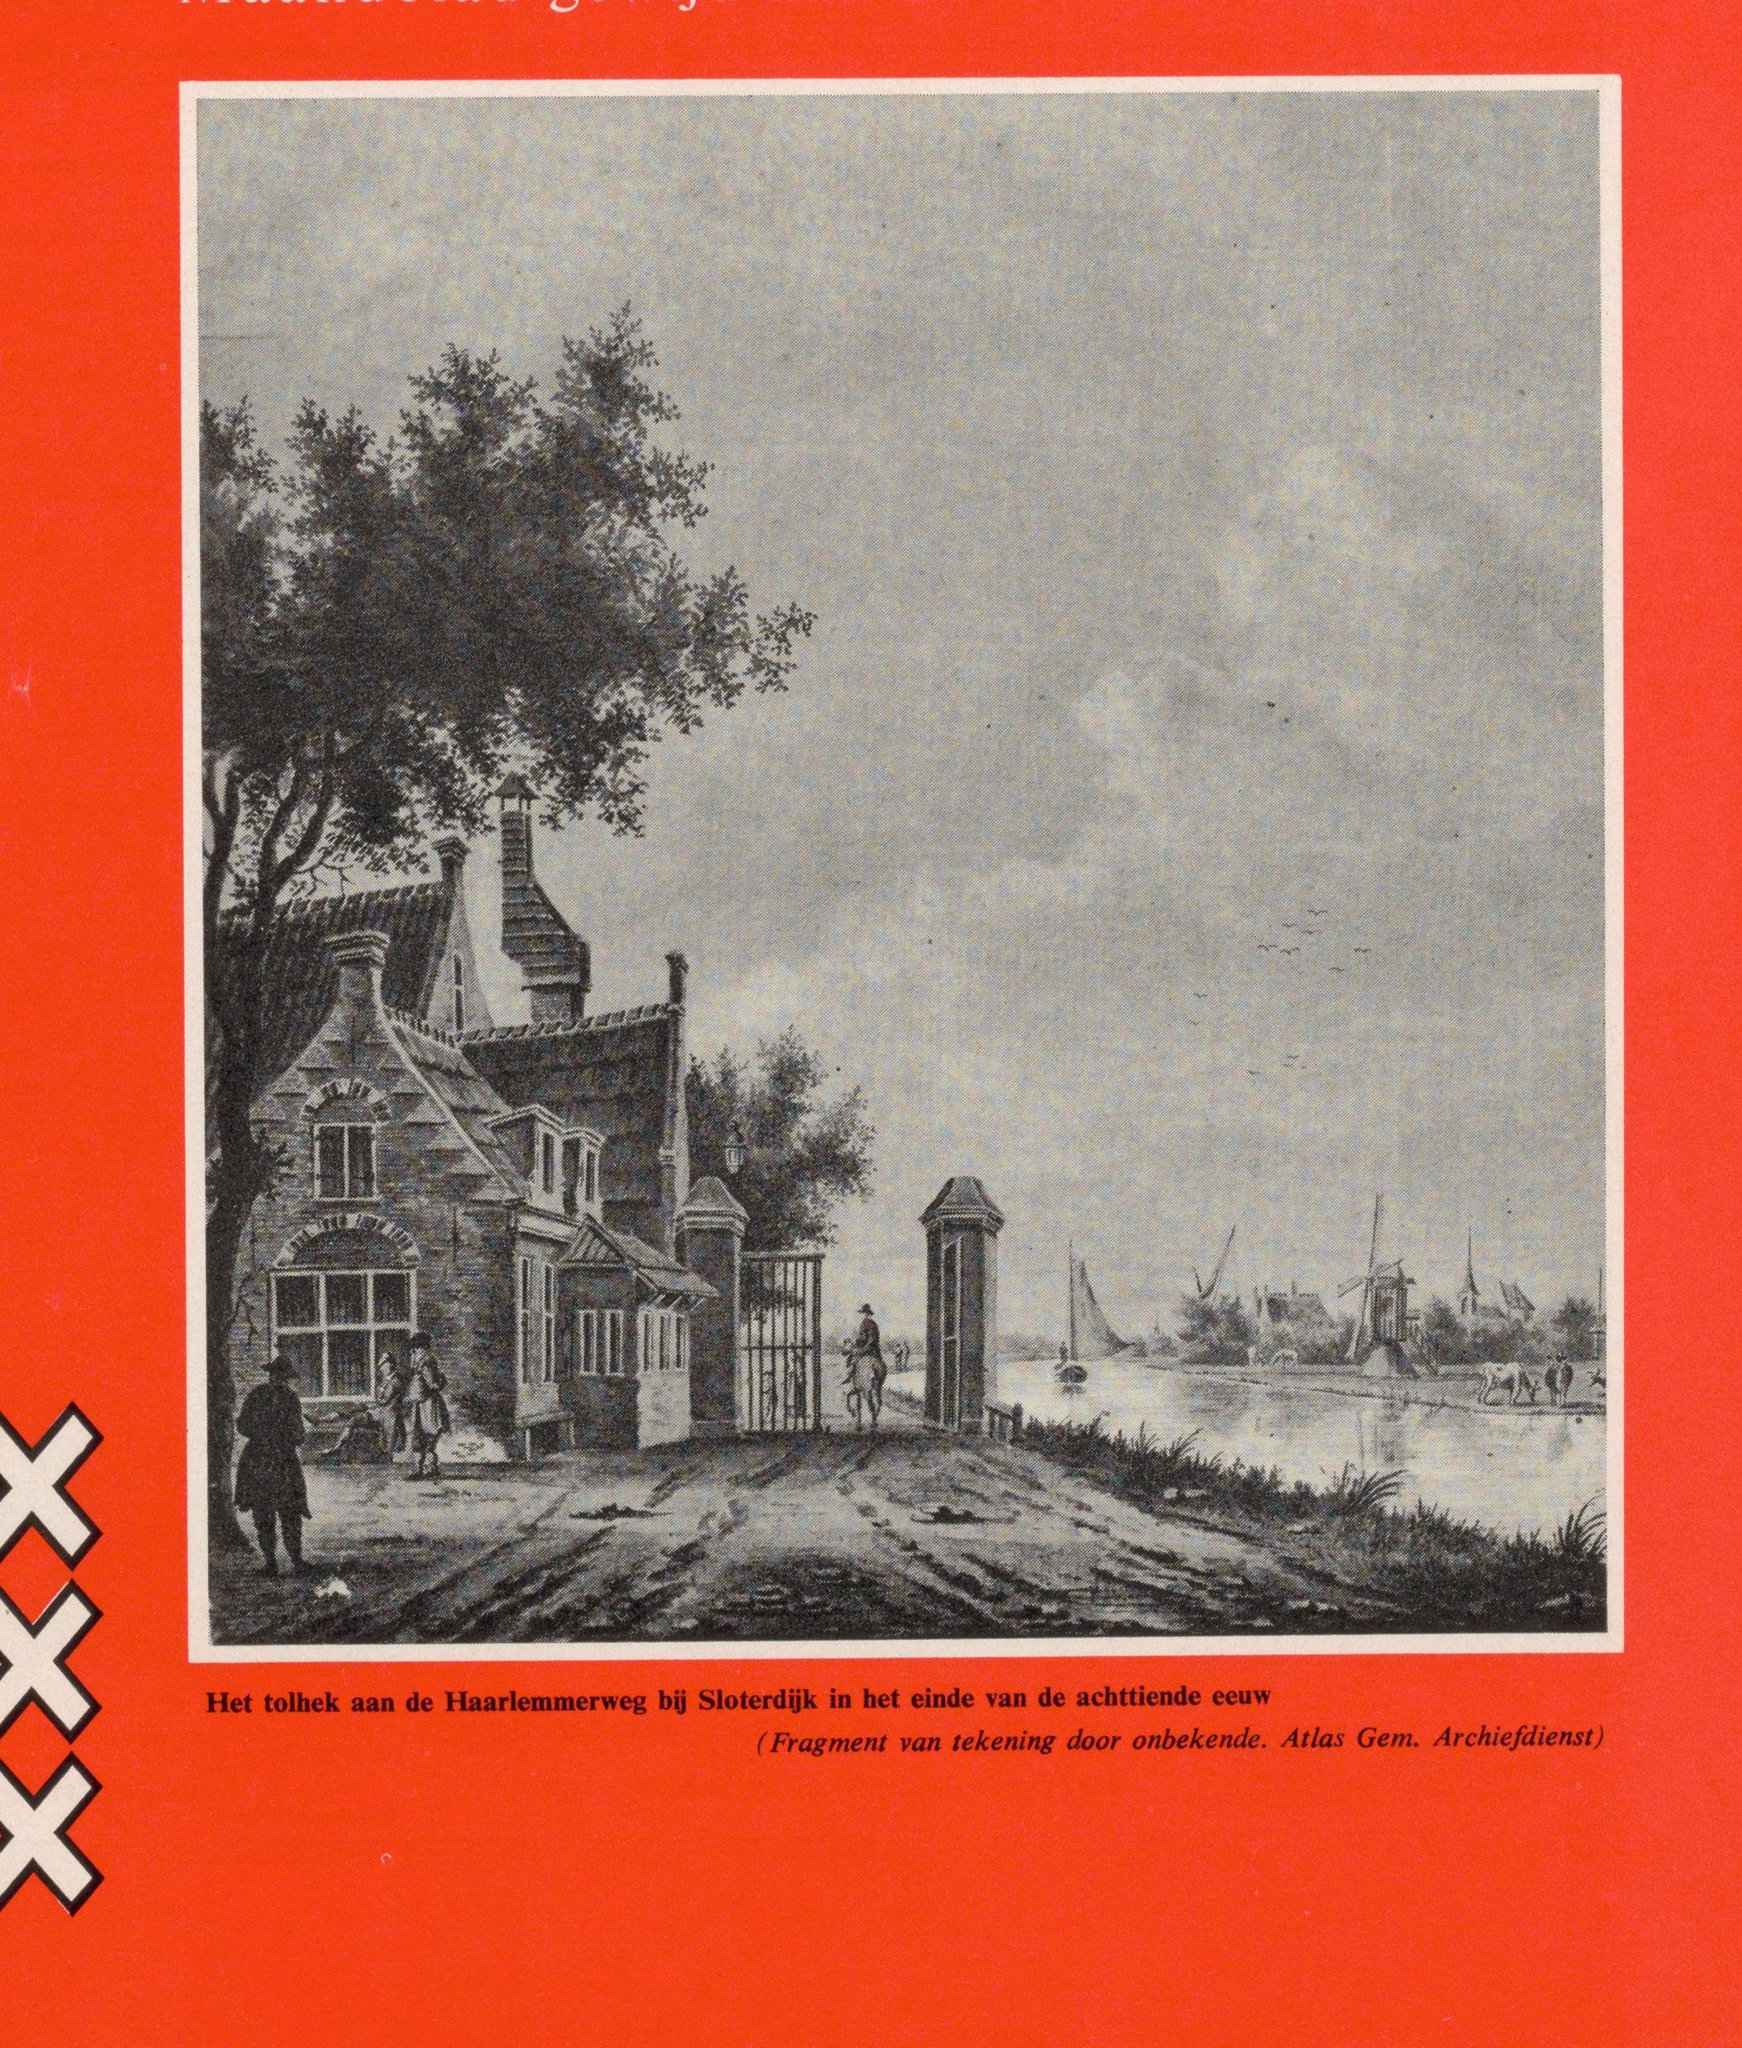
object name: magazine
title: Tijdschrift uit archief Jan Veth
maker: b. ram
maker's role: auteur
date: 1904-1967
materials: paper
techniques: printing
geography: amsterdam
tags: dordrecht, amsterdam, painter, draughtsman, designer, jan veth, middelburg, politician, pieter lodewijk tak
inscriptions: collector's mark: ‘RPK’